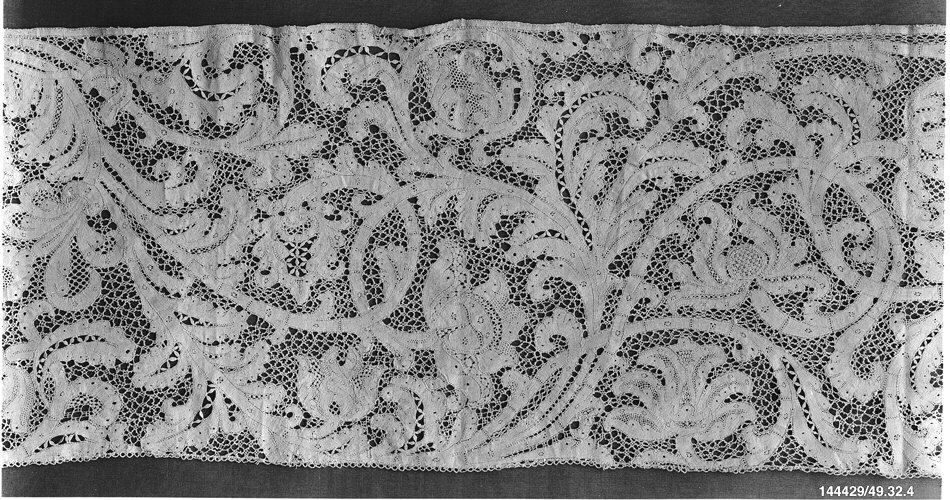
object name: insertion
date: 1601-1700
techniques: lace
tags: flowers